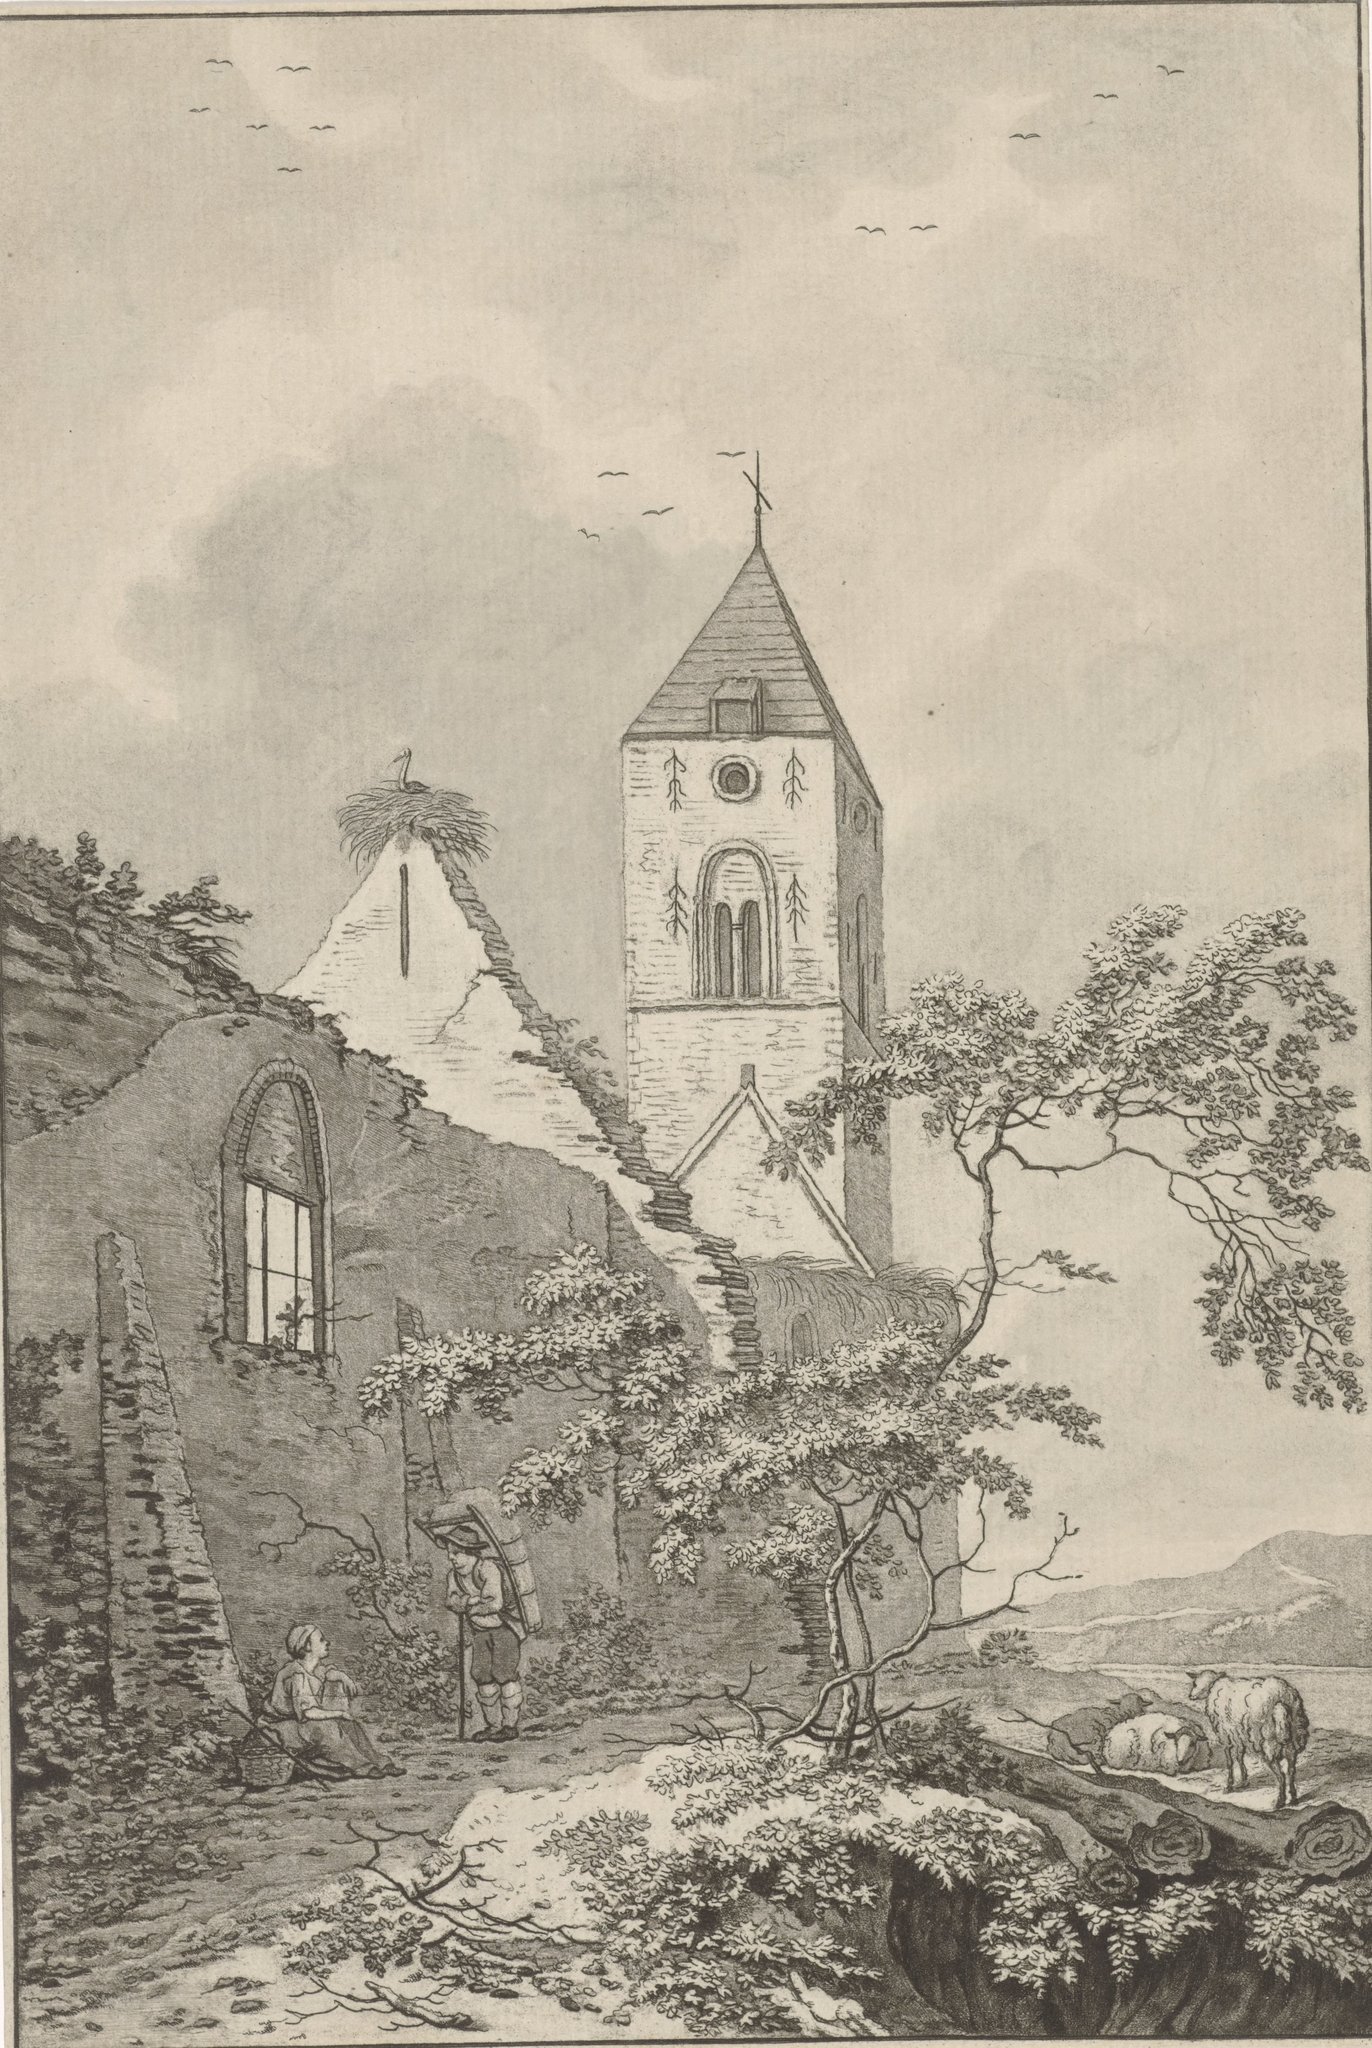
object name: print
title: Twee rustende figuren bij de ruïne van een kerk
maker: noach van der meer (ii)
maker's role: draughtsman, print maker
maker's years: 1741-1822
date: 1785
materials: paper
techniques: aquatint, etching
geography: amsterdam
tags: (traveller) resting in the open air, ruin of church, monastery, etc., sheep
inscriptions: inscription: ‘door Noach v.d. Meer junior naar Dan. du Pré / geoffereert aan den Oeconomieschen Tak te Haarlem / en met een remuneratie van 10 ducaten beloont / in 't jaar 1785 / present gedaan aan den weled Heer van Leyden, Heer van Vlaardingen etc. etc. / N. v.d. Meer’, collector's mark: Lugt 240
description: Twee figuren rusten bij de ruïne van een kerk. Rechts schapen.